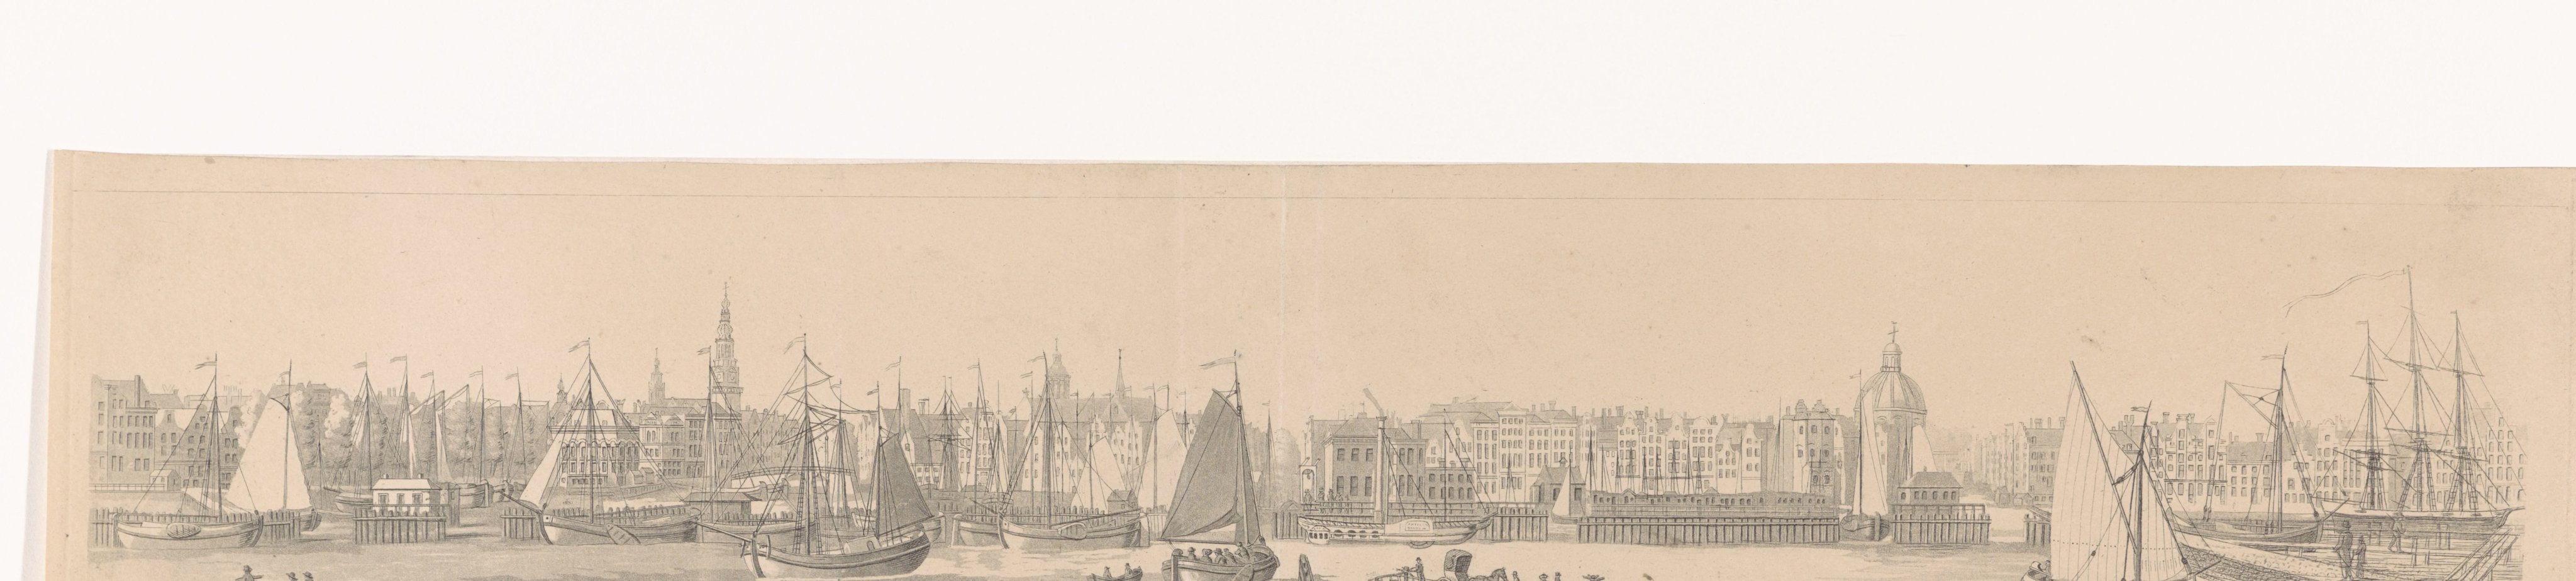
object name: print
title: Panorama van Amsterdam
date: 1792-1847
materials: paper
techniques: aquatint, engraving, etching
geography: amsterdam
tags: prospect of city, town panorama, silhouette of city, amsterdam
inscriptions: collector's mark: Lugt 2228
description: Gezicht vanaf het IJ op het centrum van Amsterdam, met van links naar rechts de Oude Kerkstoren, het torentje van het stadhuis en de Nieuwe Kerkstoren en de ronde toren van de Lutherse Kerk. Op de voorgrond schepen.